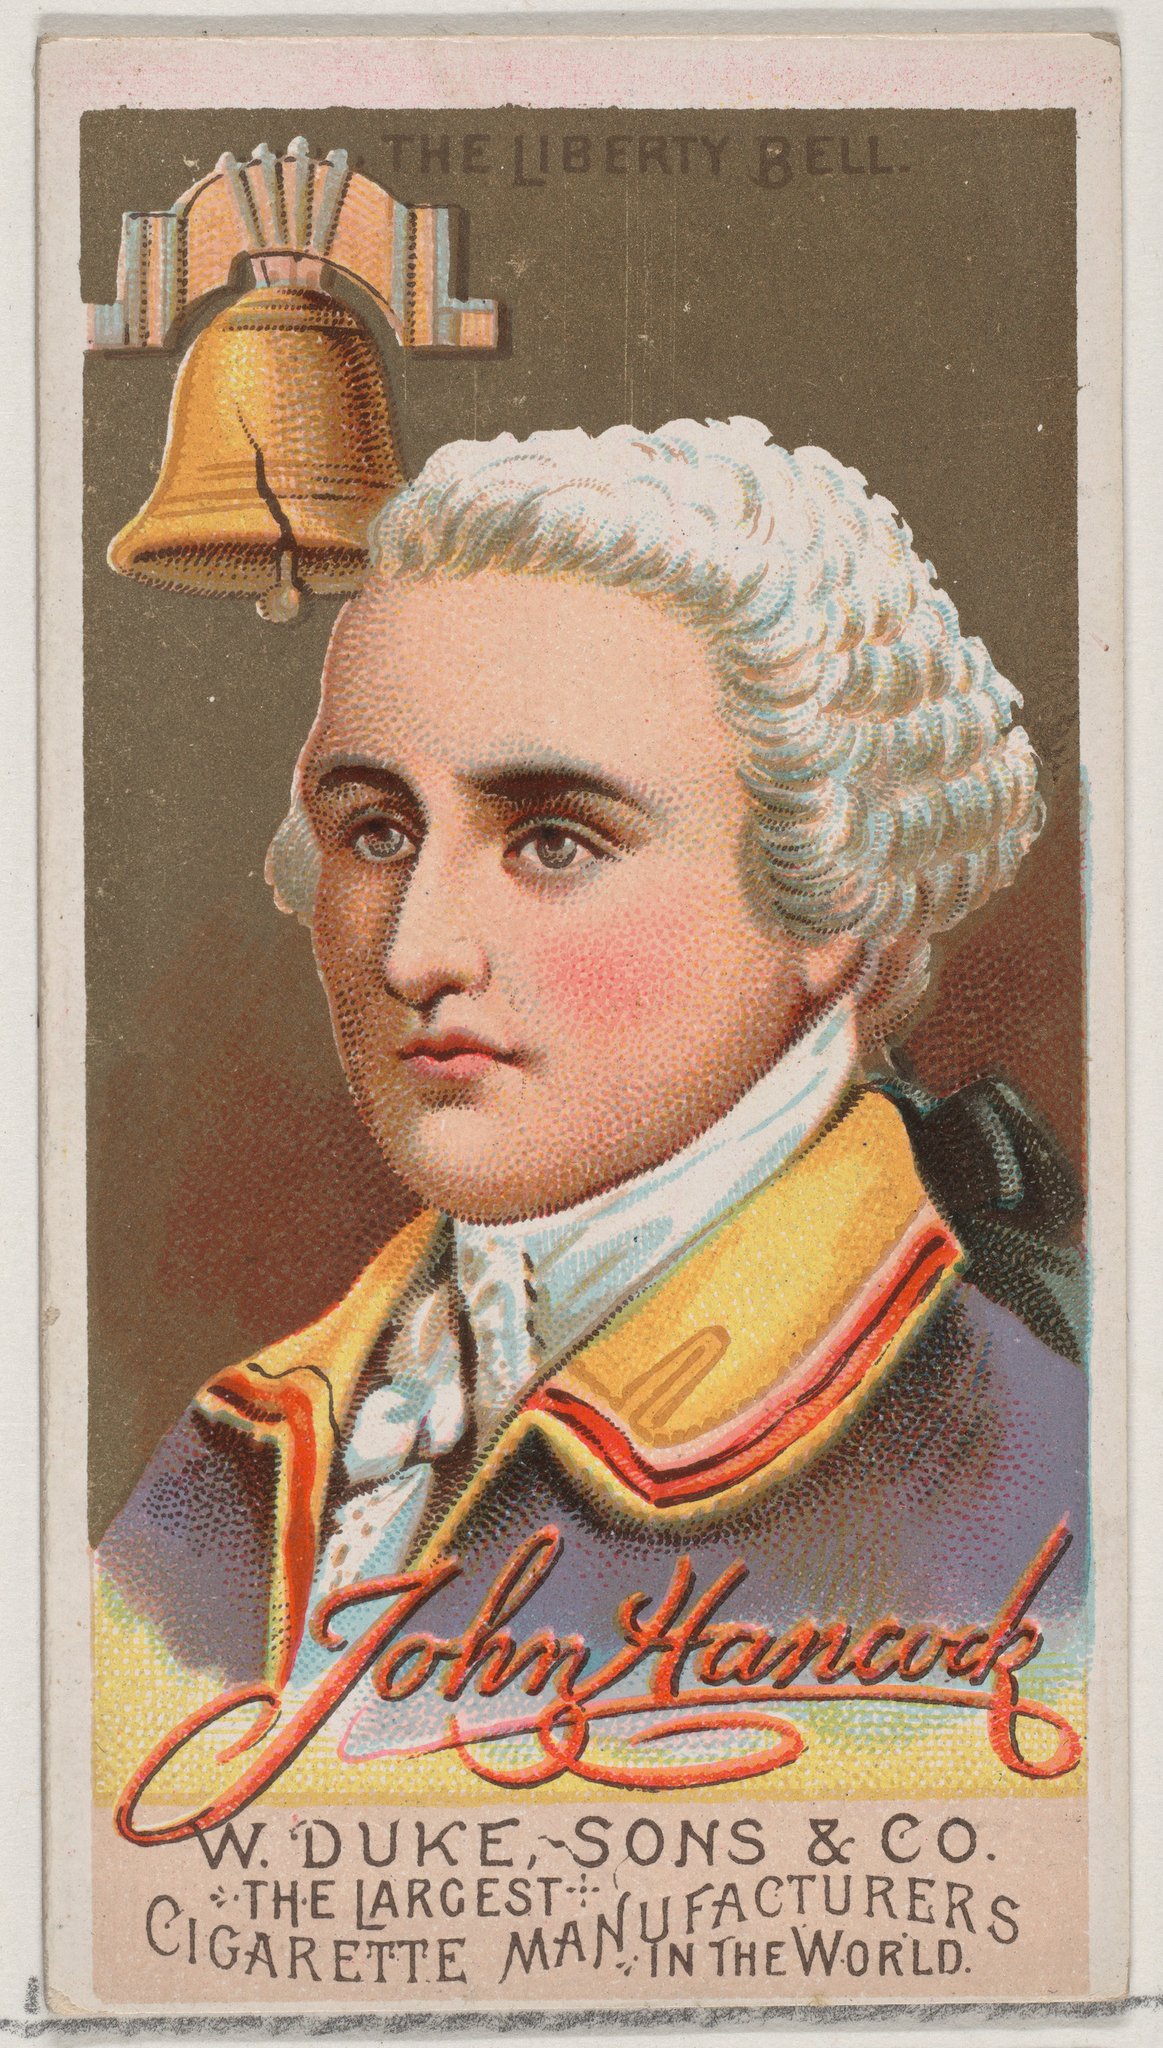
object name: print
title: John Hancock, from the series Great Americans (N76) for Duke brand cigarettes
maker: w. duke, sons & co.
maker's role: publisher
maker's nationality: american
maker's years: 1870-1920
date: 1888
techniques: color lithograph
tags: men